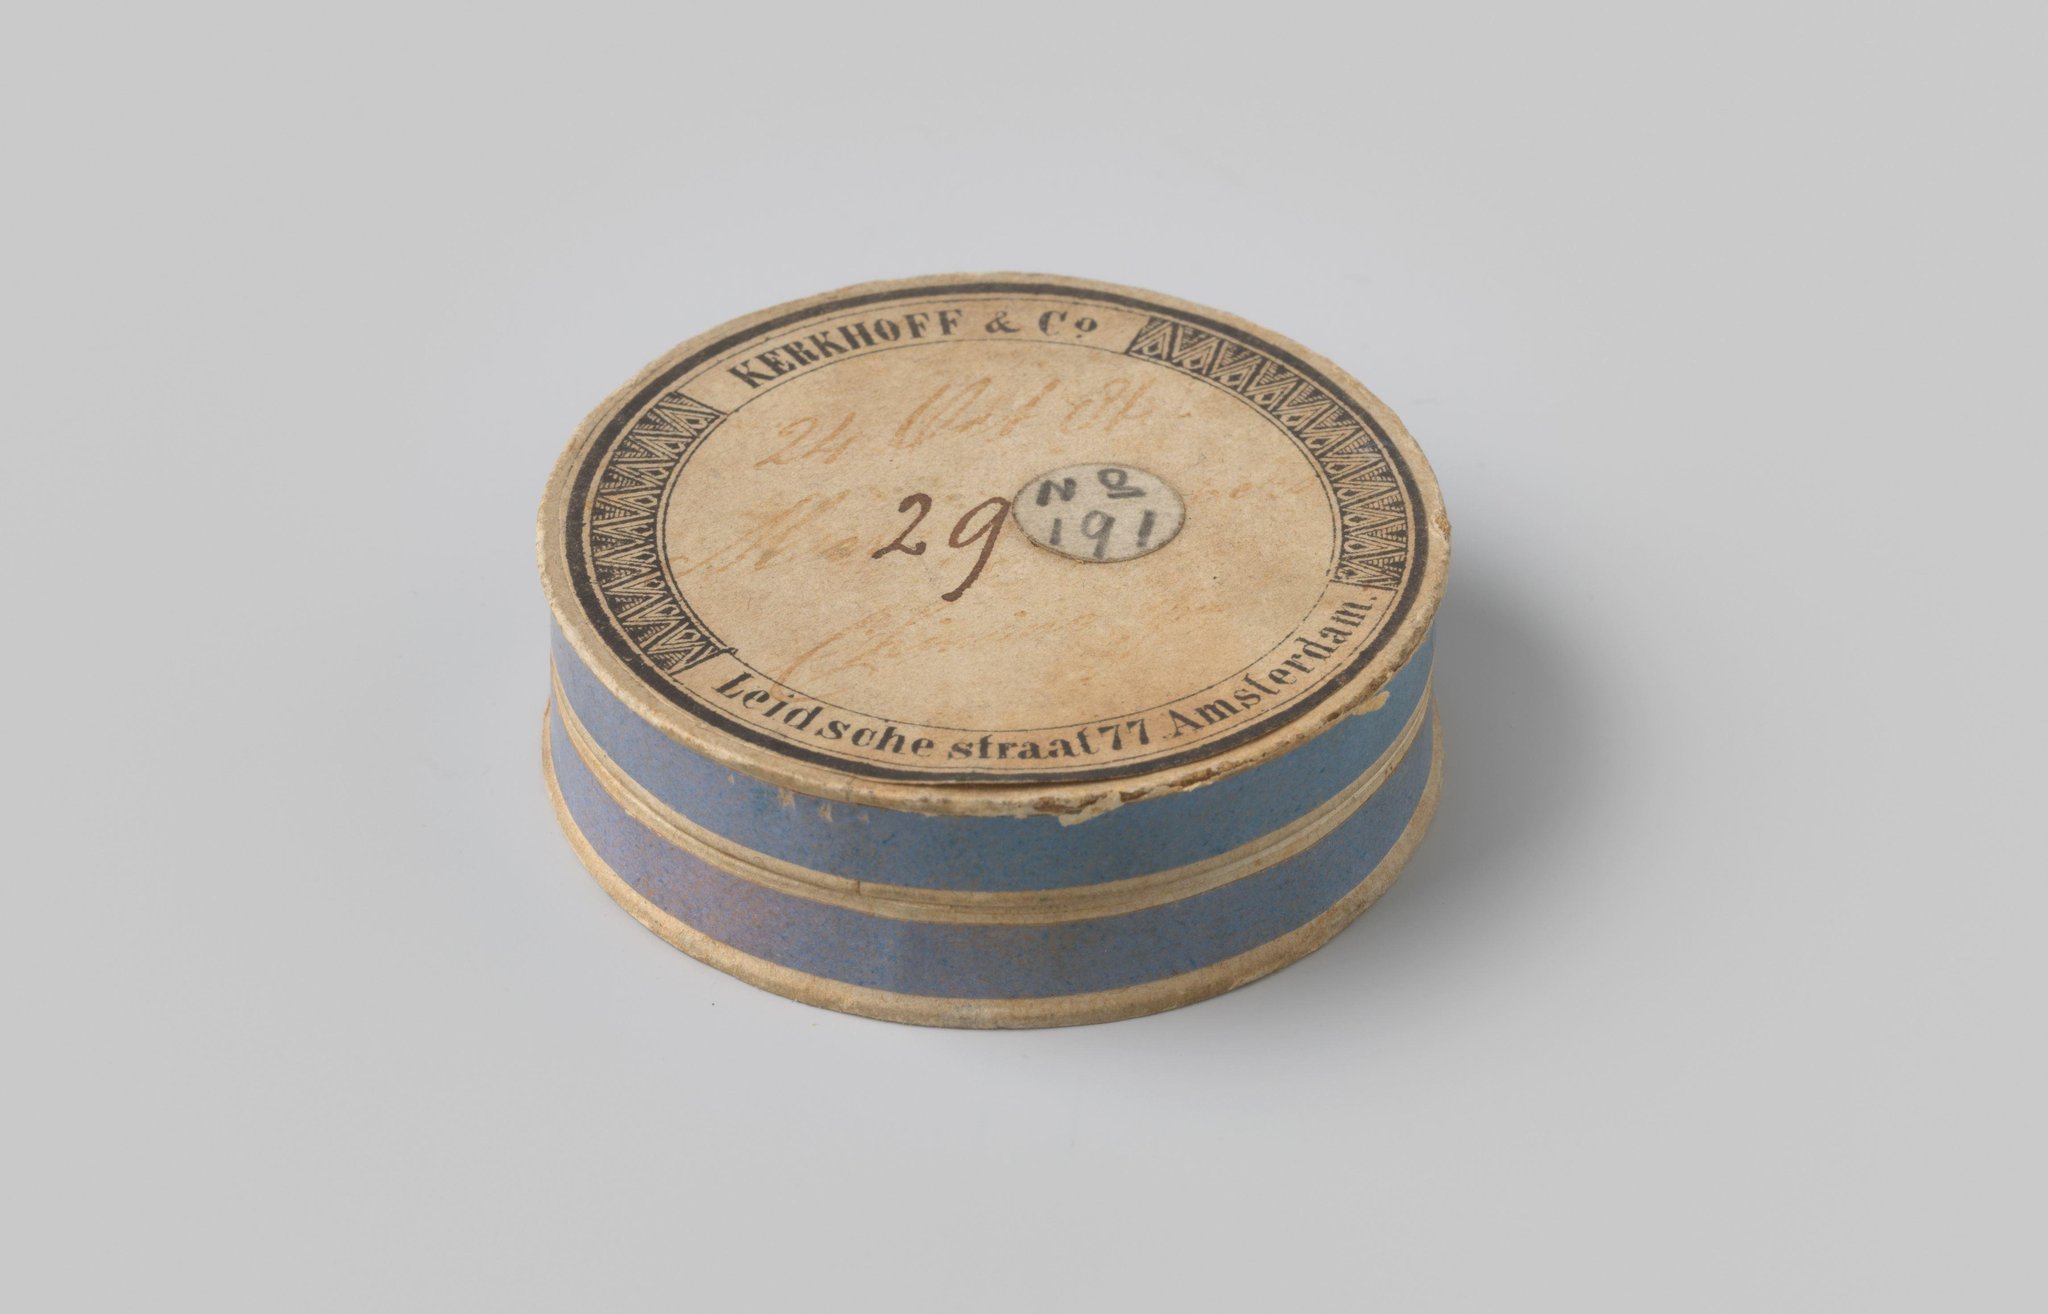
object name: box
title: Doos behorend bij een kerkelijke Oostenrijkse penning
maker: hermann wittig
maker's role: medailleur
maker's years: 1852-1889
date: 1880-1889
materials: cardboard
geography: rome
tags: austria, rome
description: Ronde kartonnen doos behorend bij een bronzen penning.